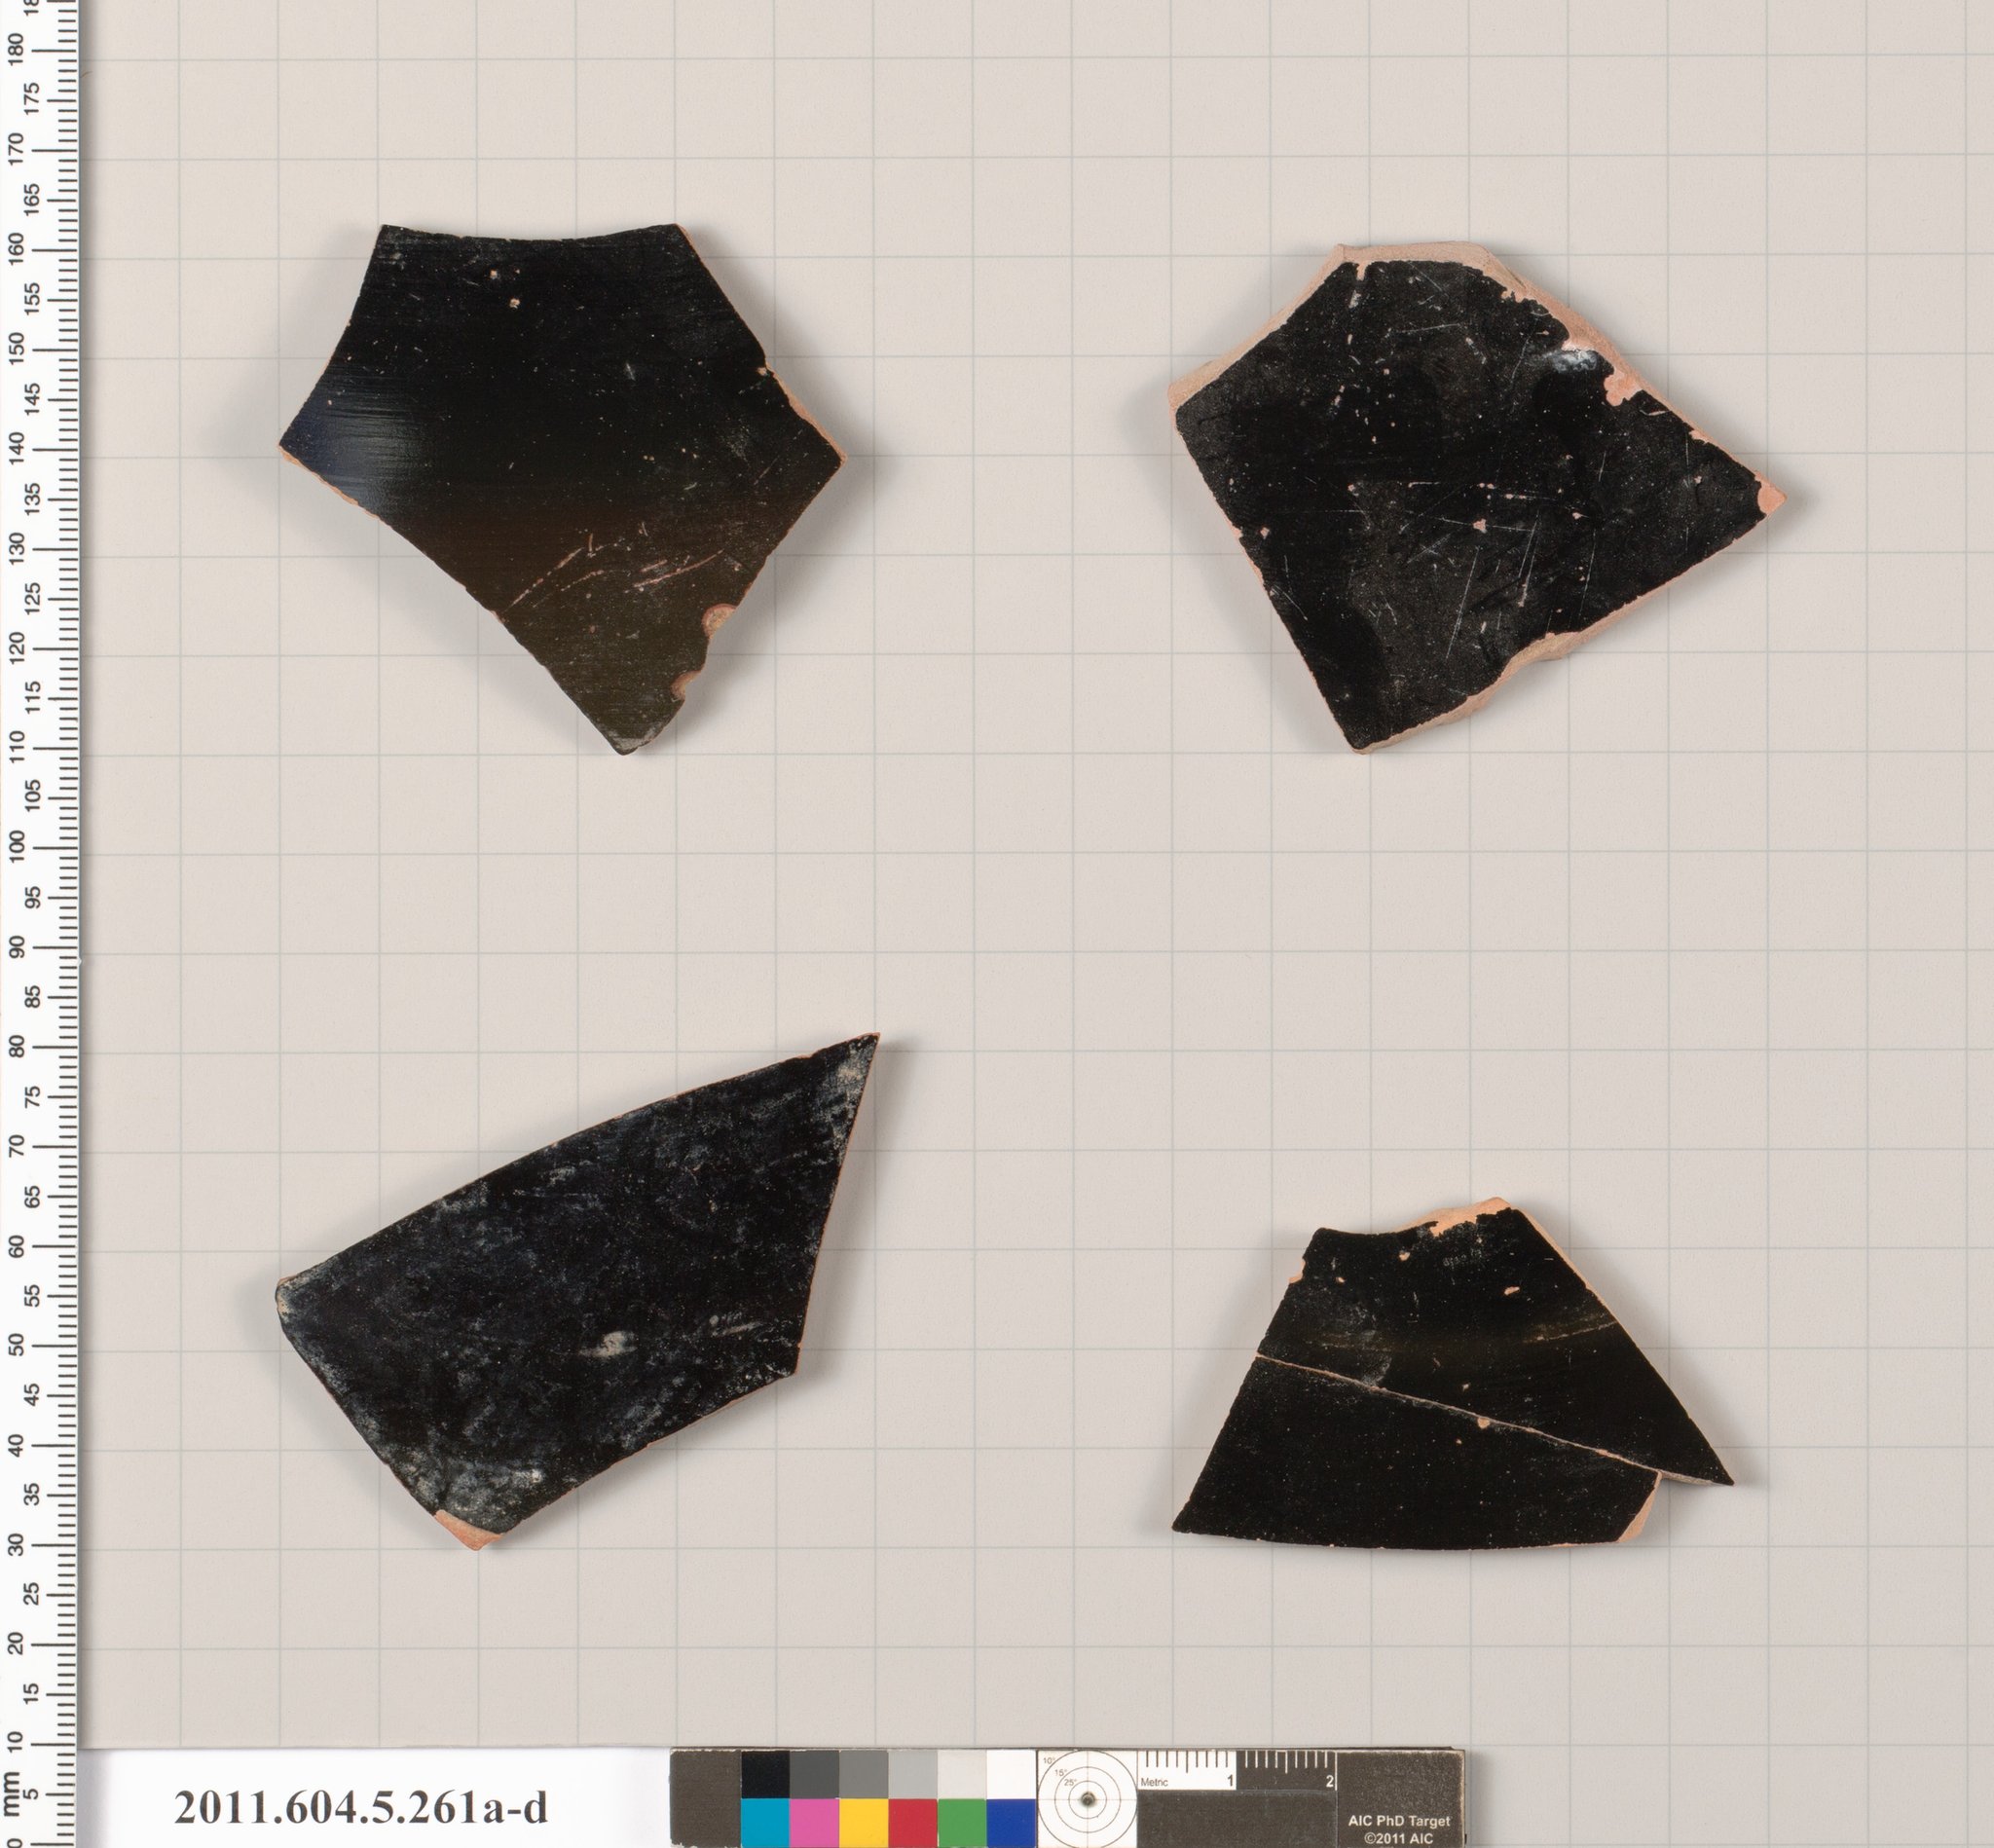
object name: kylix fragment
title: Terracotta fragments of kylikes (drinking cups)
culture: greek, attic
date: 600-401 BCE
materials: terracotta